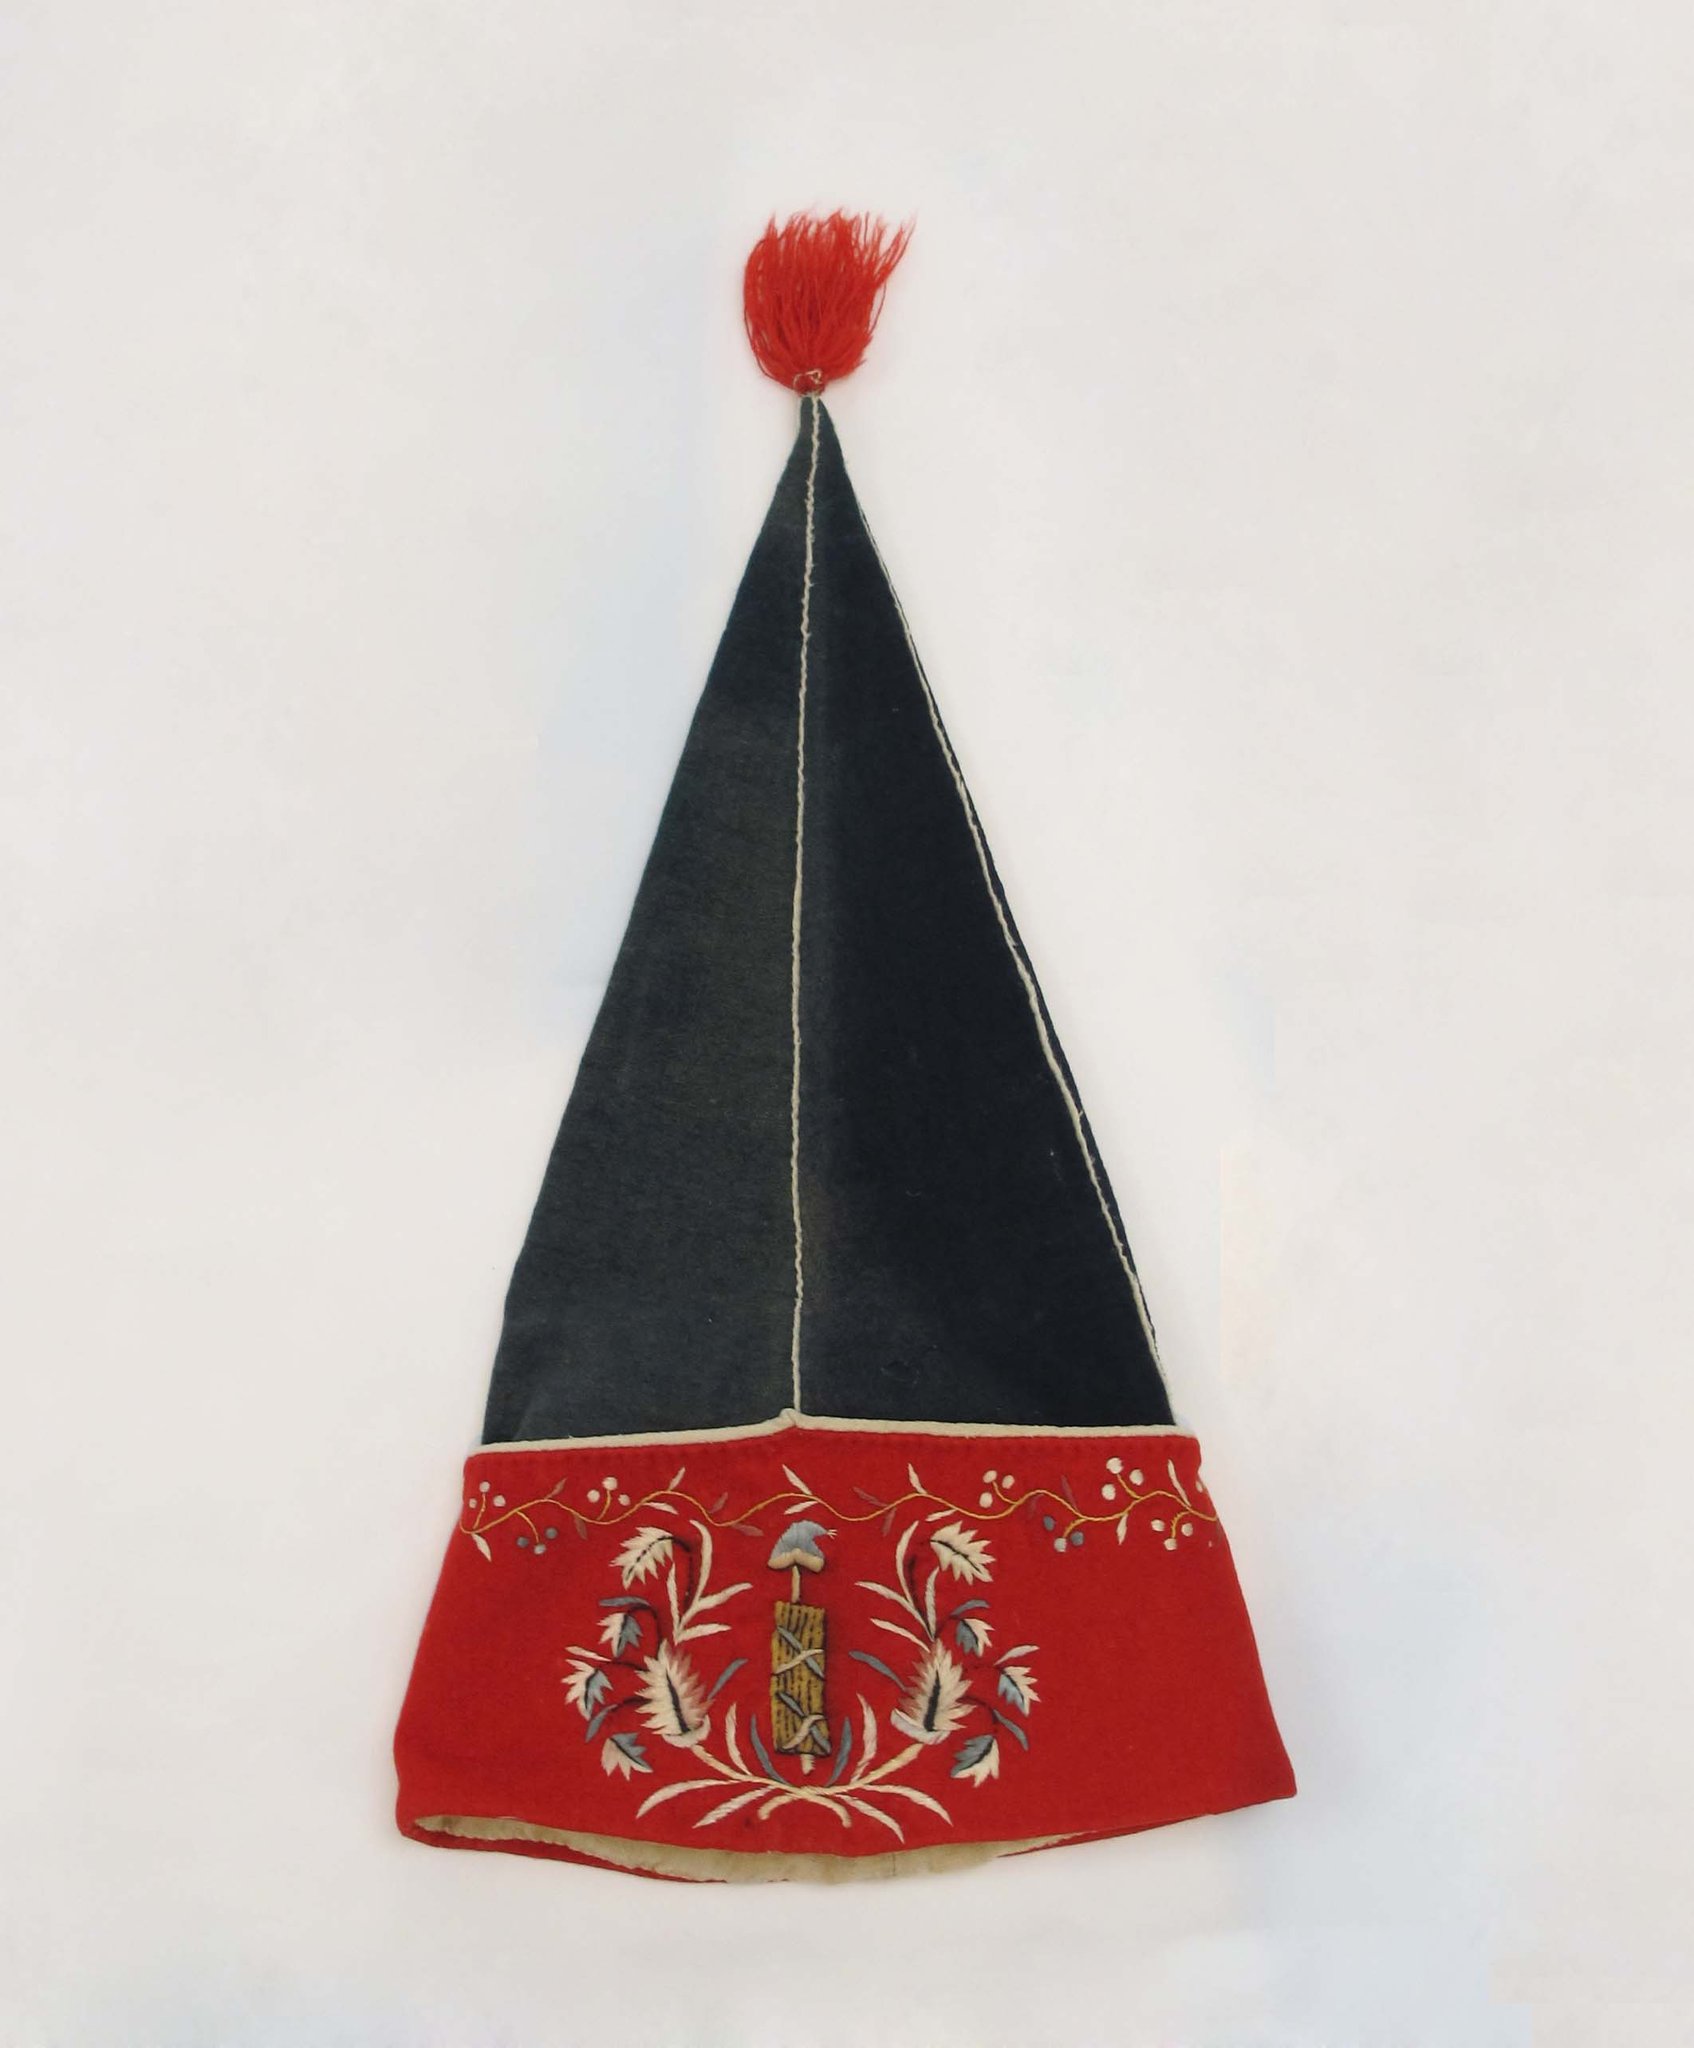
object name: cap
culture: french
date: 1790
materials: cotton, linen, wool